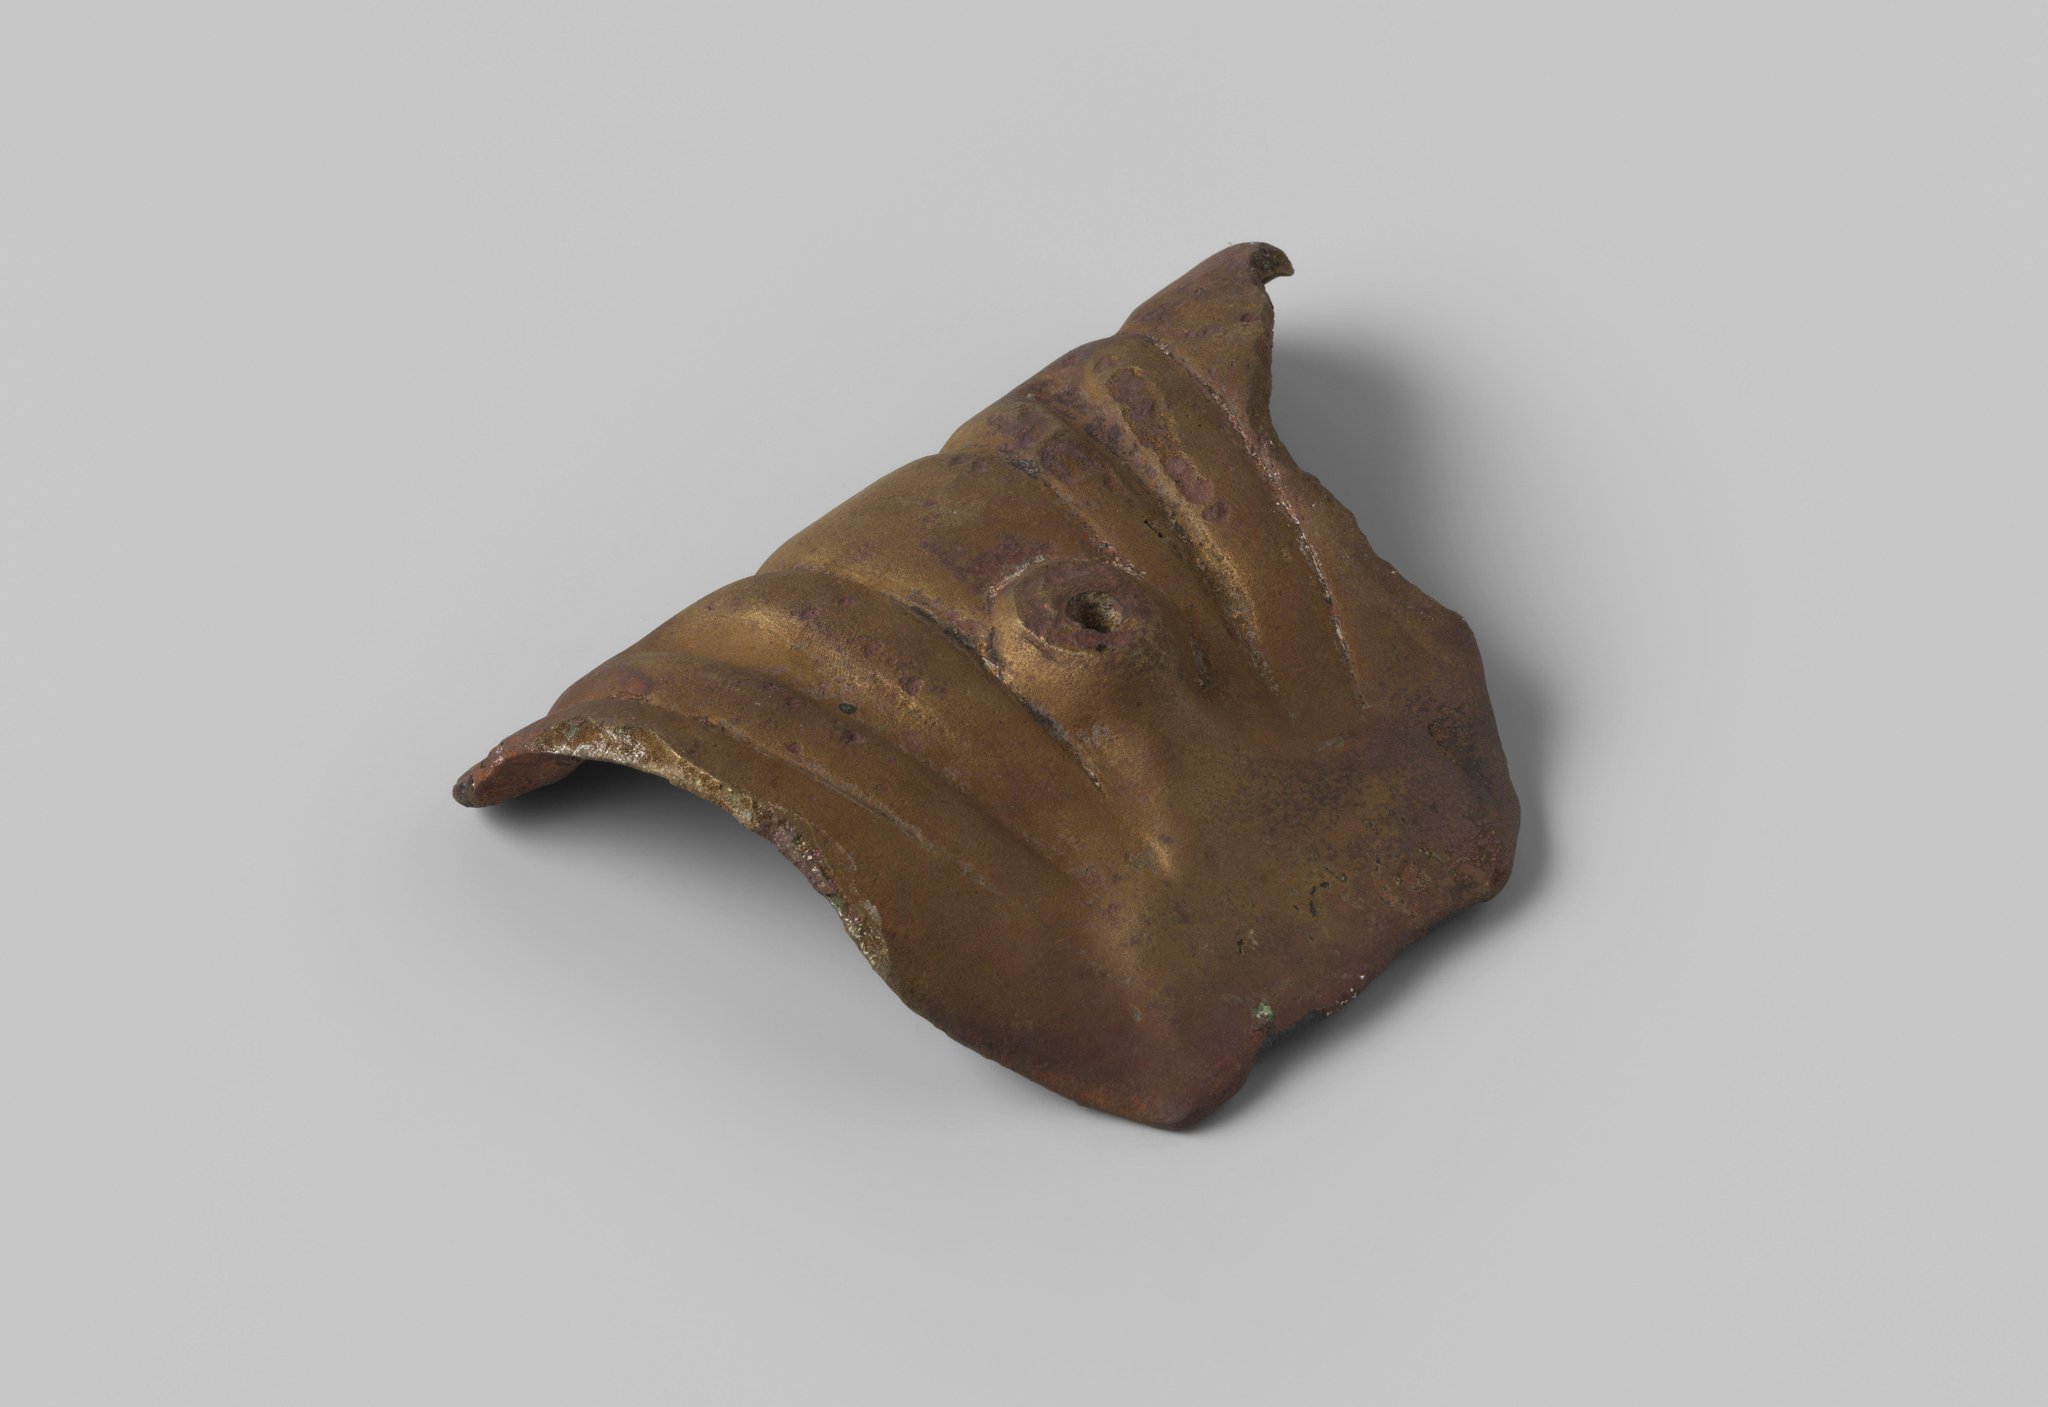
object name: mould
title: Mal uit het wrak van de Oost-Indiëvaarder Hollandia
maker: Anonymous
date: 1700-1743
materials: copper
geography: netherlands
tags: verenigde oostindische compagnie, hollandia (schip), annet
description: Tools and instruments, lead casting, mould; mould, eroded: triangular outline with straight top and base, curved, cast design on concave side, fluted (shell?) and foliate motif, on the reverse handle fitting and inscription id. NG 1979-192H3074.